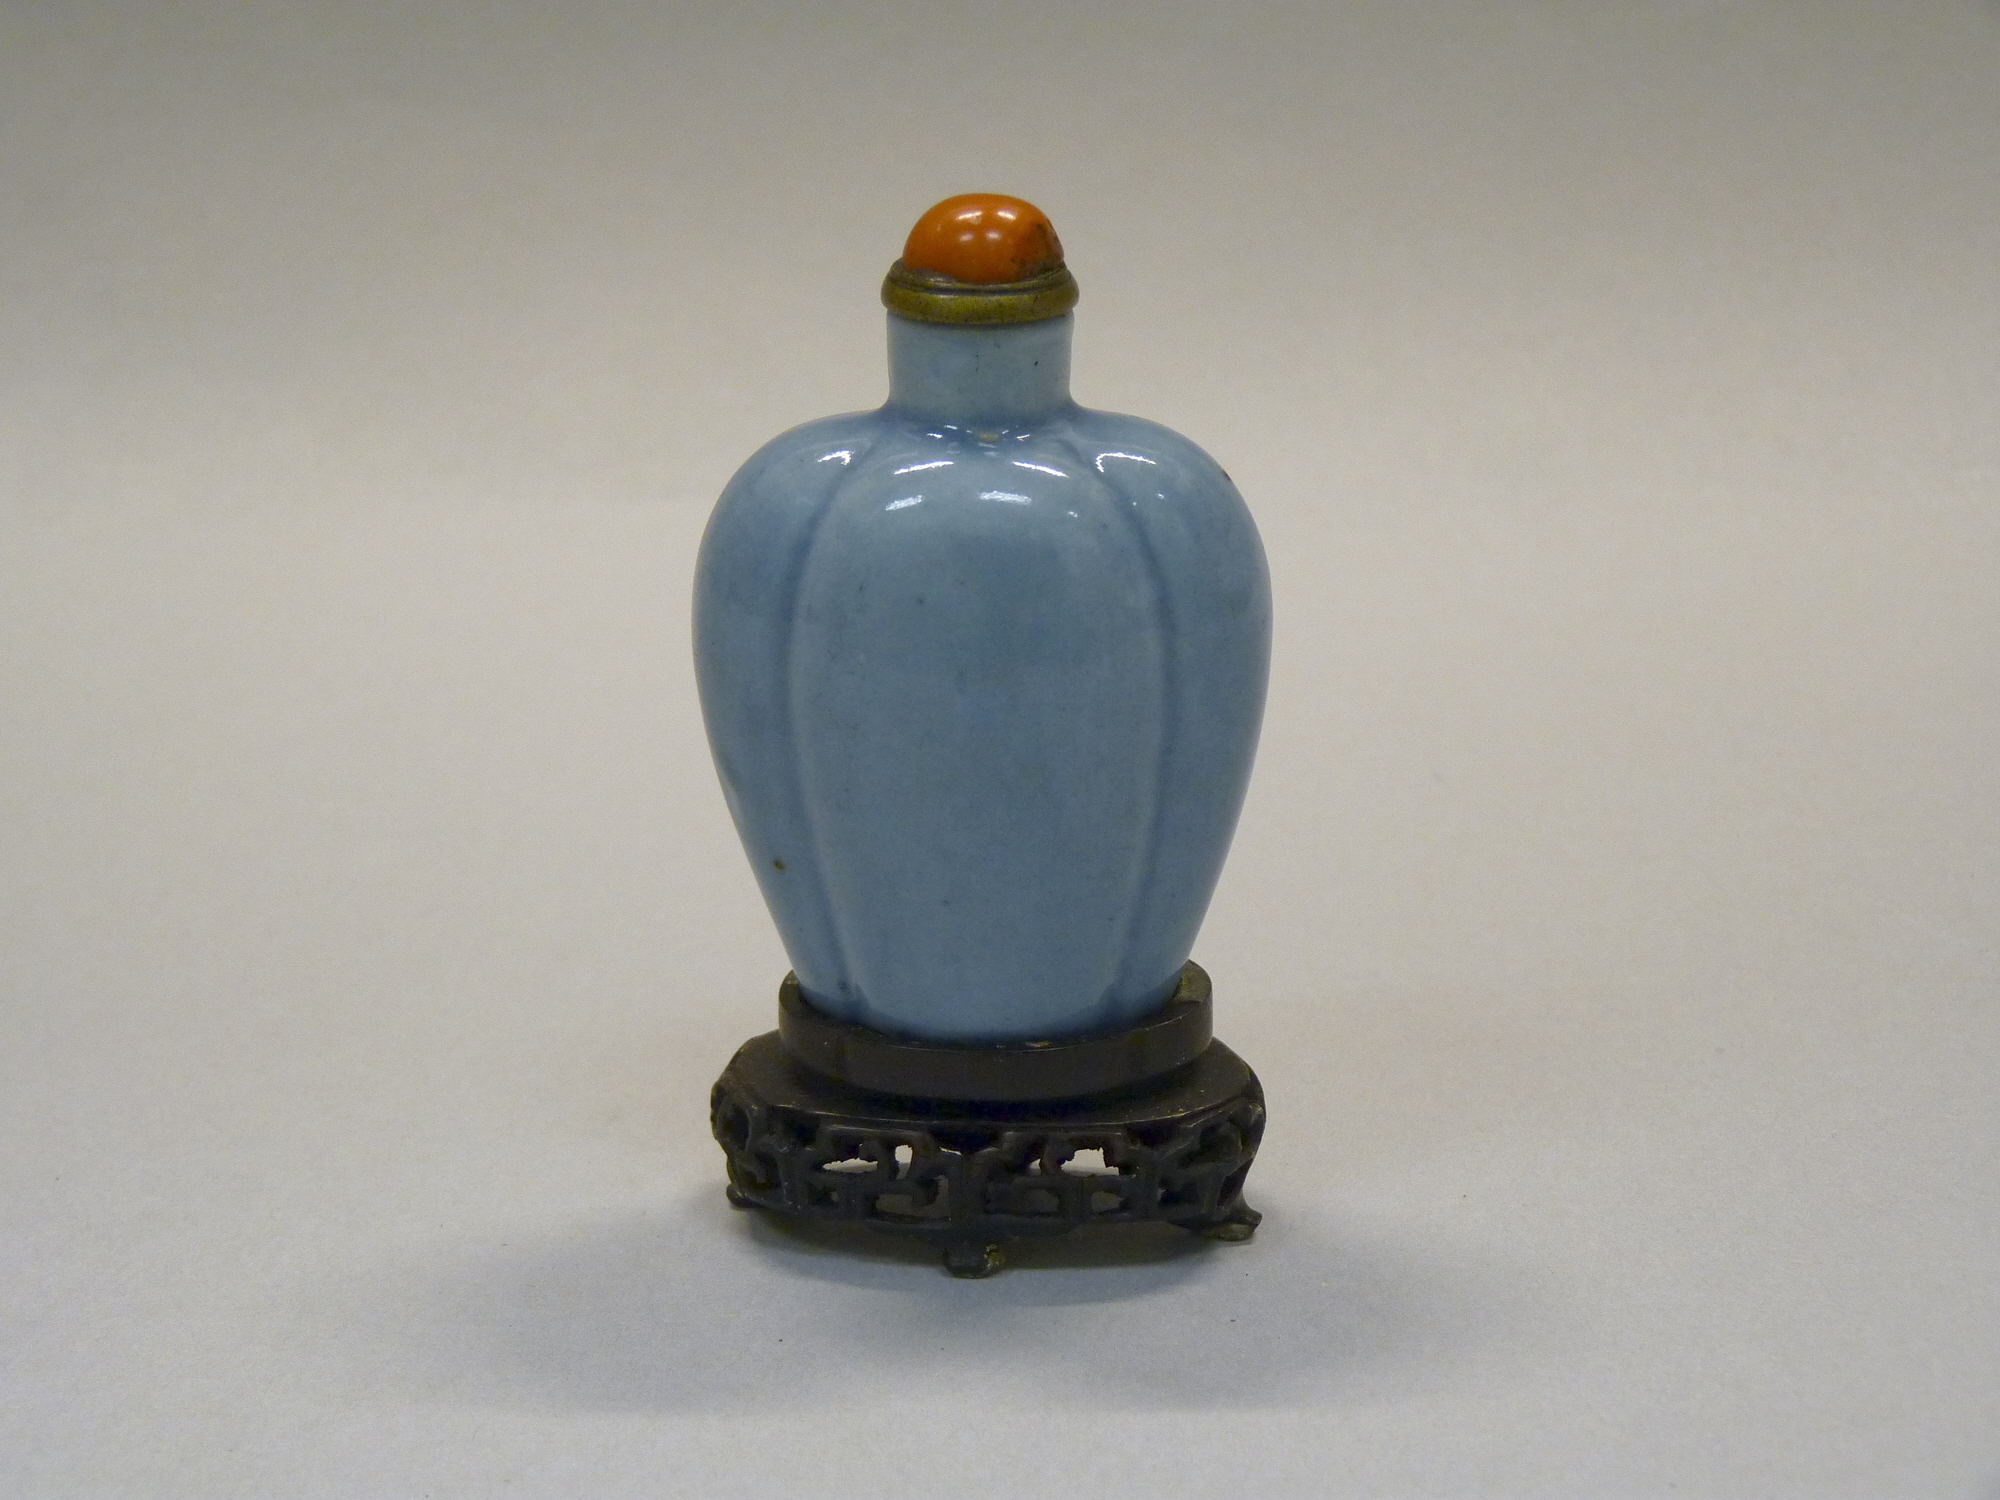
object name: snuff bottle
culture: chinese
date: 1736-1795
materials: coral, porcelain